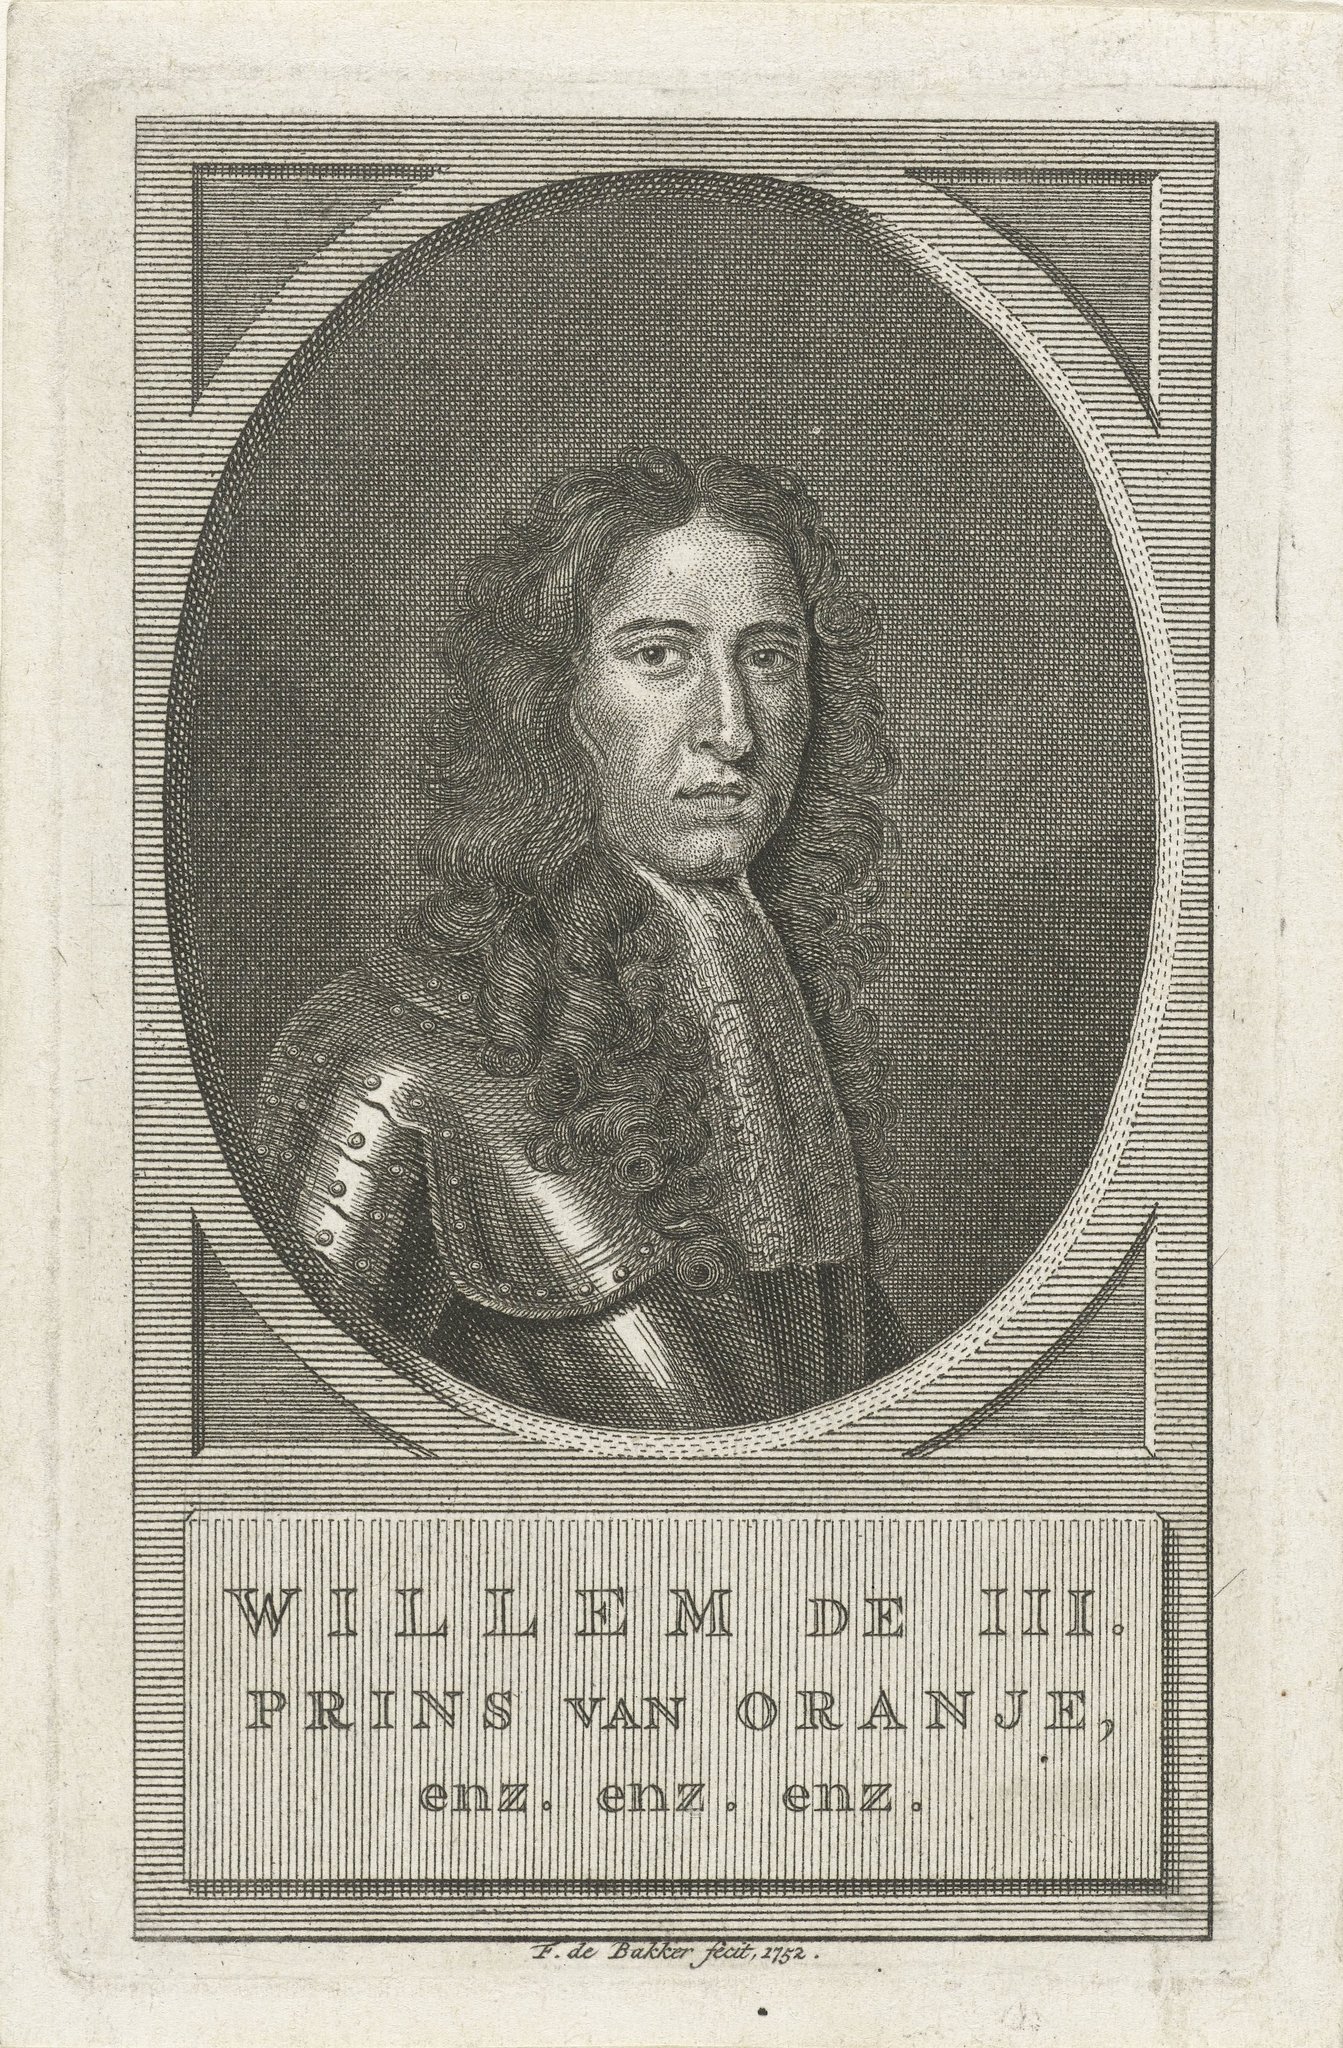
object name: print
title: Portret van Willem III prins van Oranje-Nassau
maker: frans de bakker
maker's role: print maker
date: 1752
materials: paper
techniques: etching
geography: amsterdam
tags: the hague, william iii (prince of orange and king of england, scotland, and ireland)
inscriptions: collector's mark: Lugt 2228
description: Portret van Willem III prins van Oranje-Nassau in ovaal. Onder het portret zijn naam.